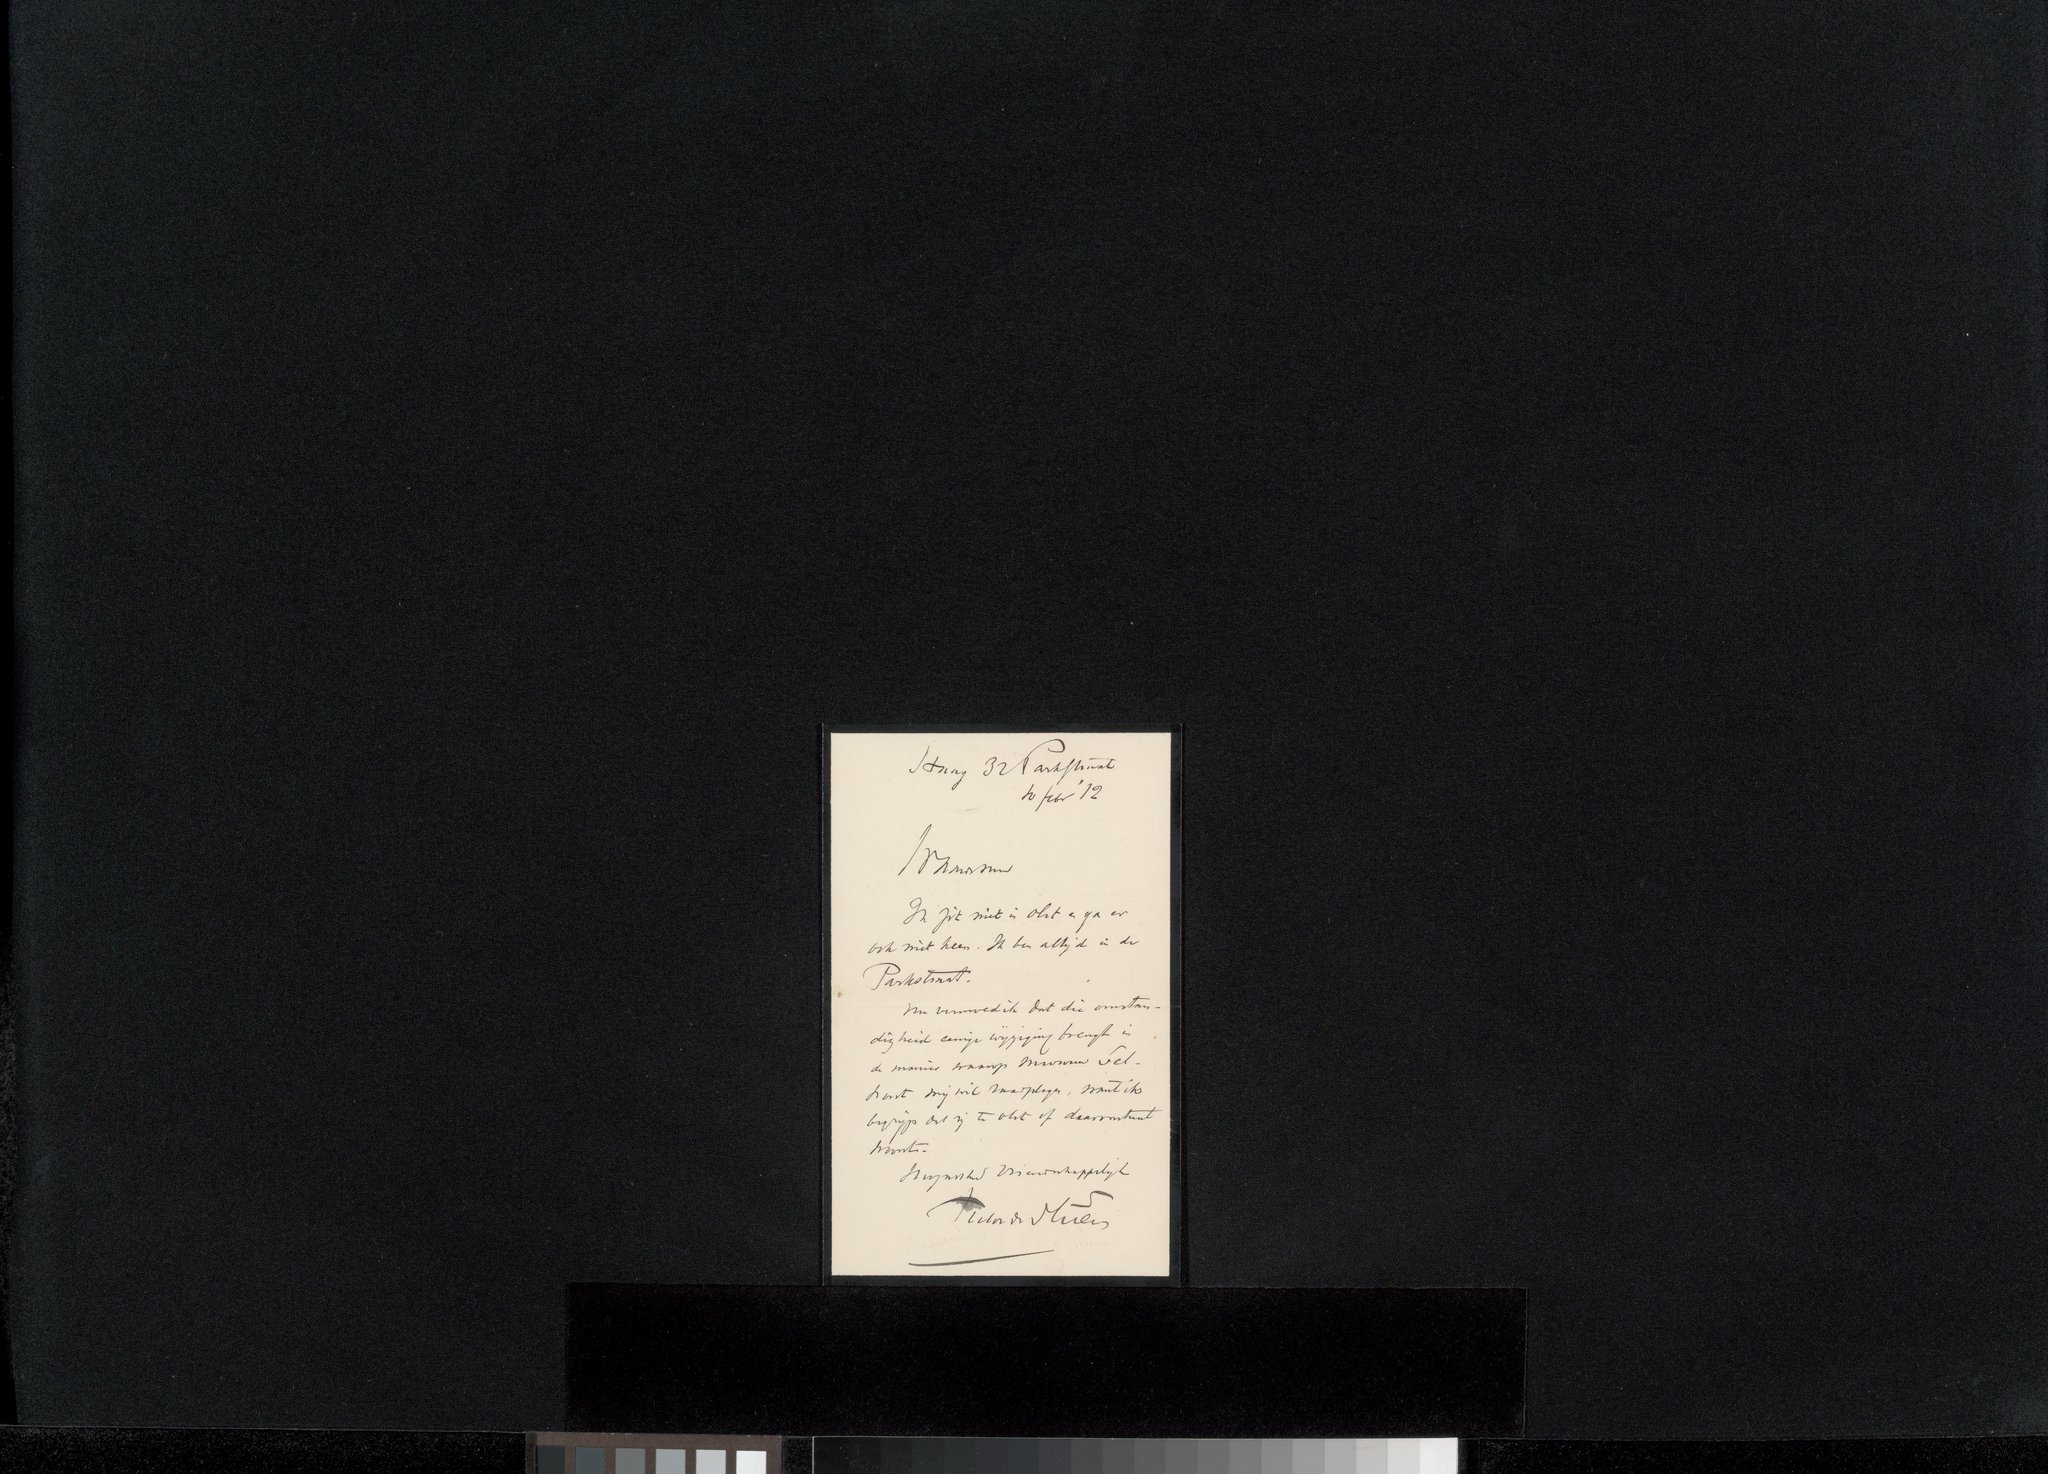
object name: letter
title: Brief aan Philip Zilcken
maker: jonkheer victor eugène louis de stuers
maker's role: draughtsman, print maker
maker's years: 1843-1916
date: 1912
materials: ink, paper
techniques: pen, writing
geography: the hague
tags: nonnée selhorst, painter, philip zilcken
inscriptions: collector's mark: ‘RPK’, watermark